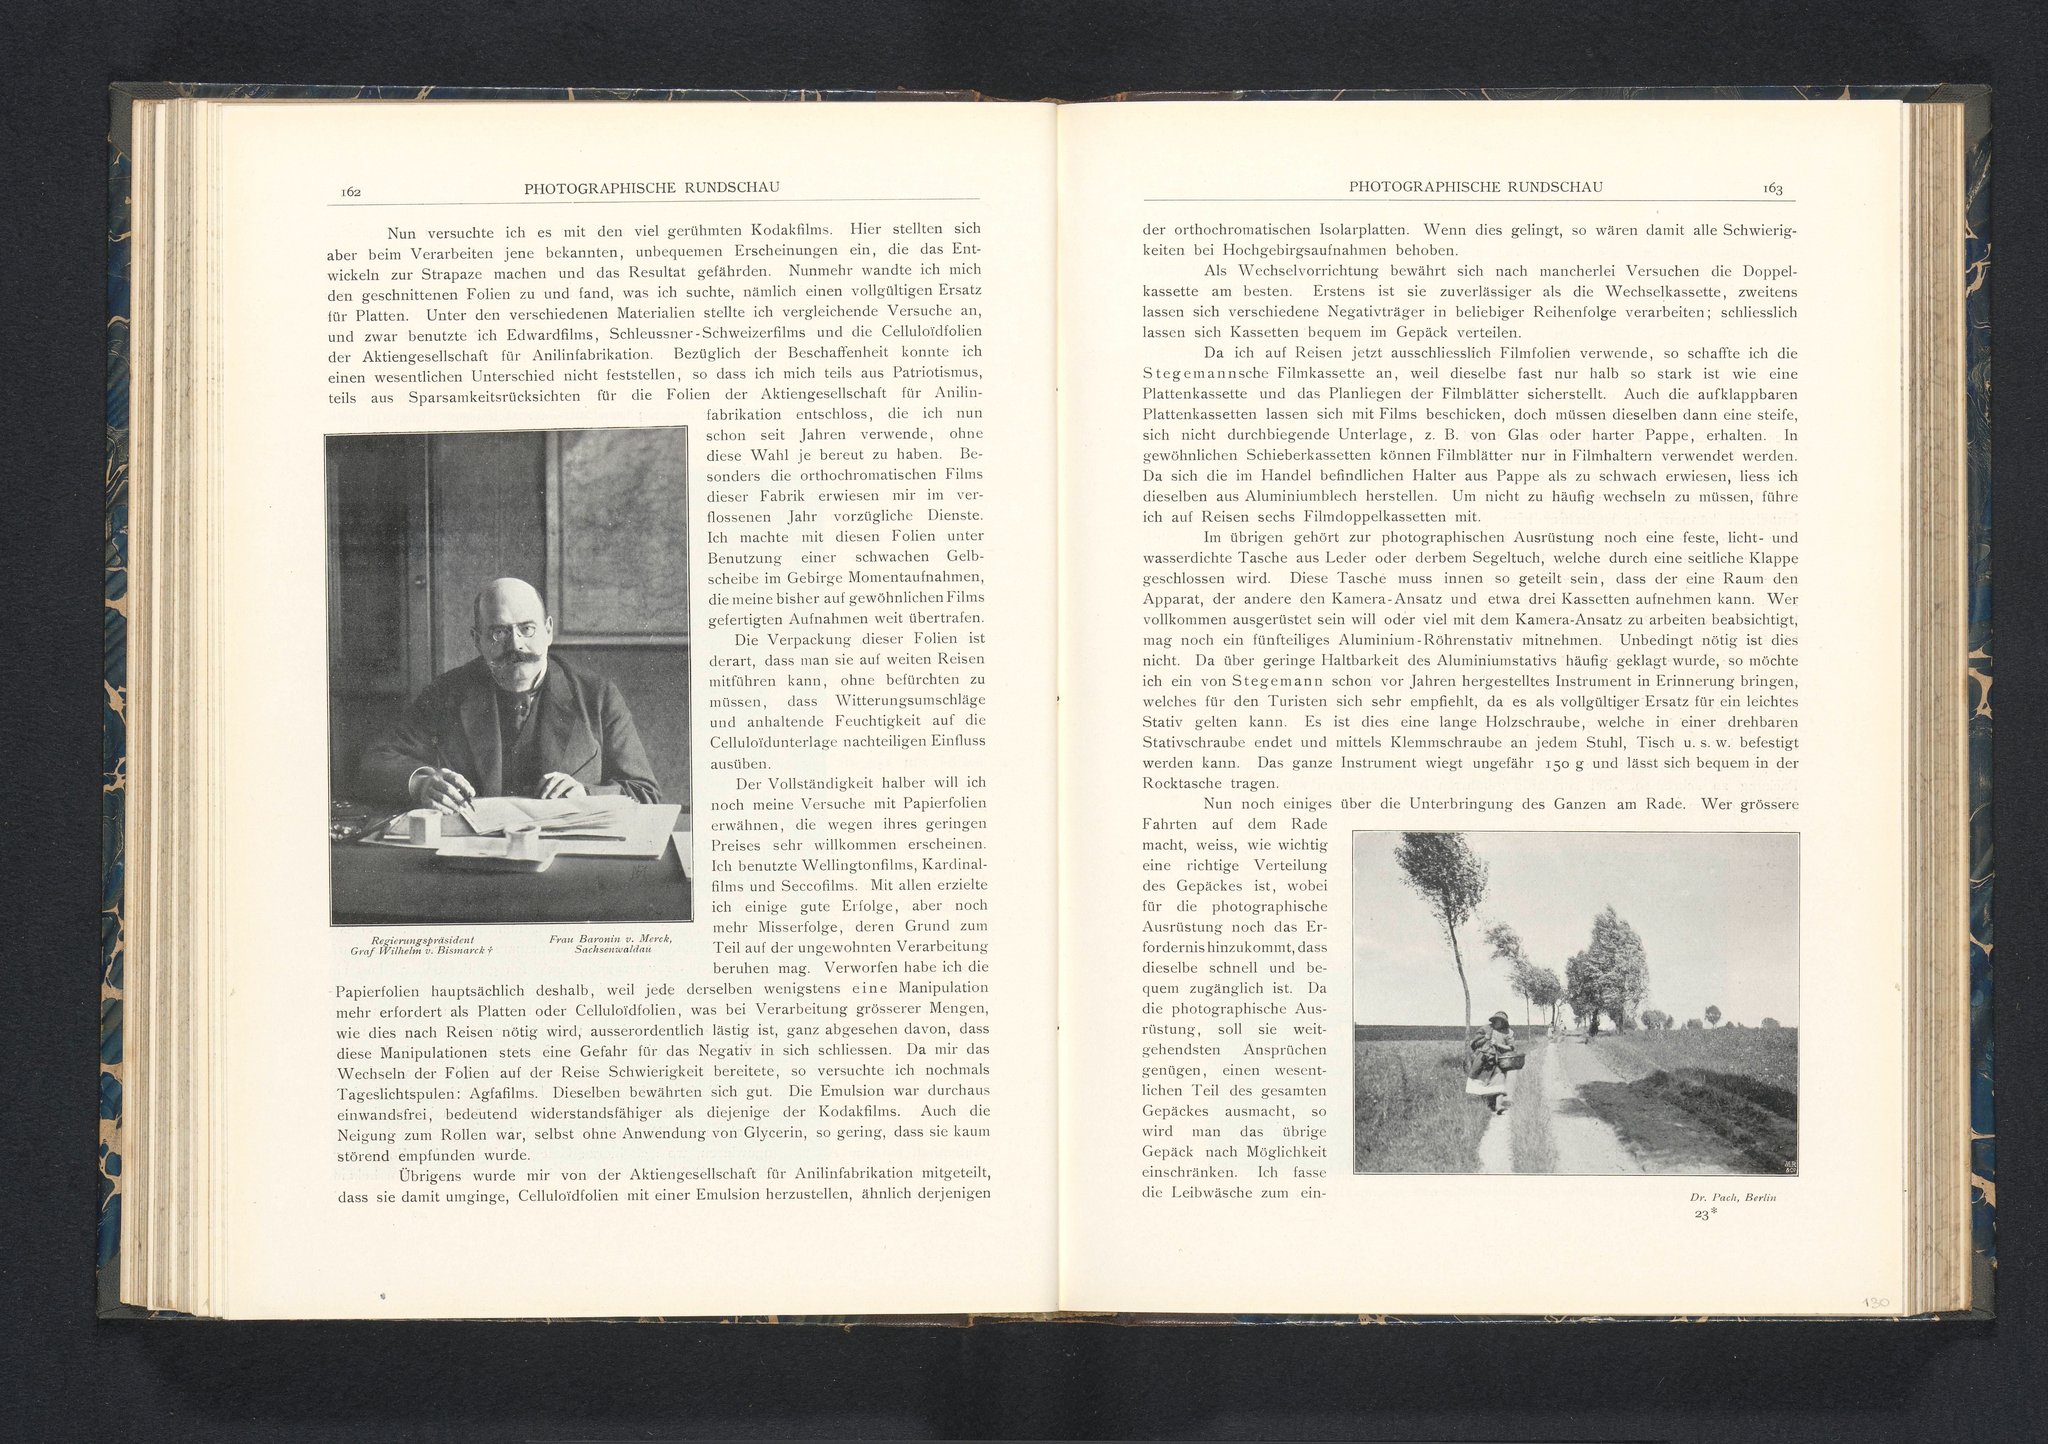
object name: page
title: Regierungspräsident Graf Wilhelm v. Bismarck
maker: barones merck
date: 1896-1901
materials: paper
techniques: autotype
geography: berlin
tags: historical persons